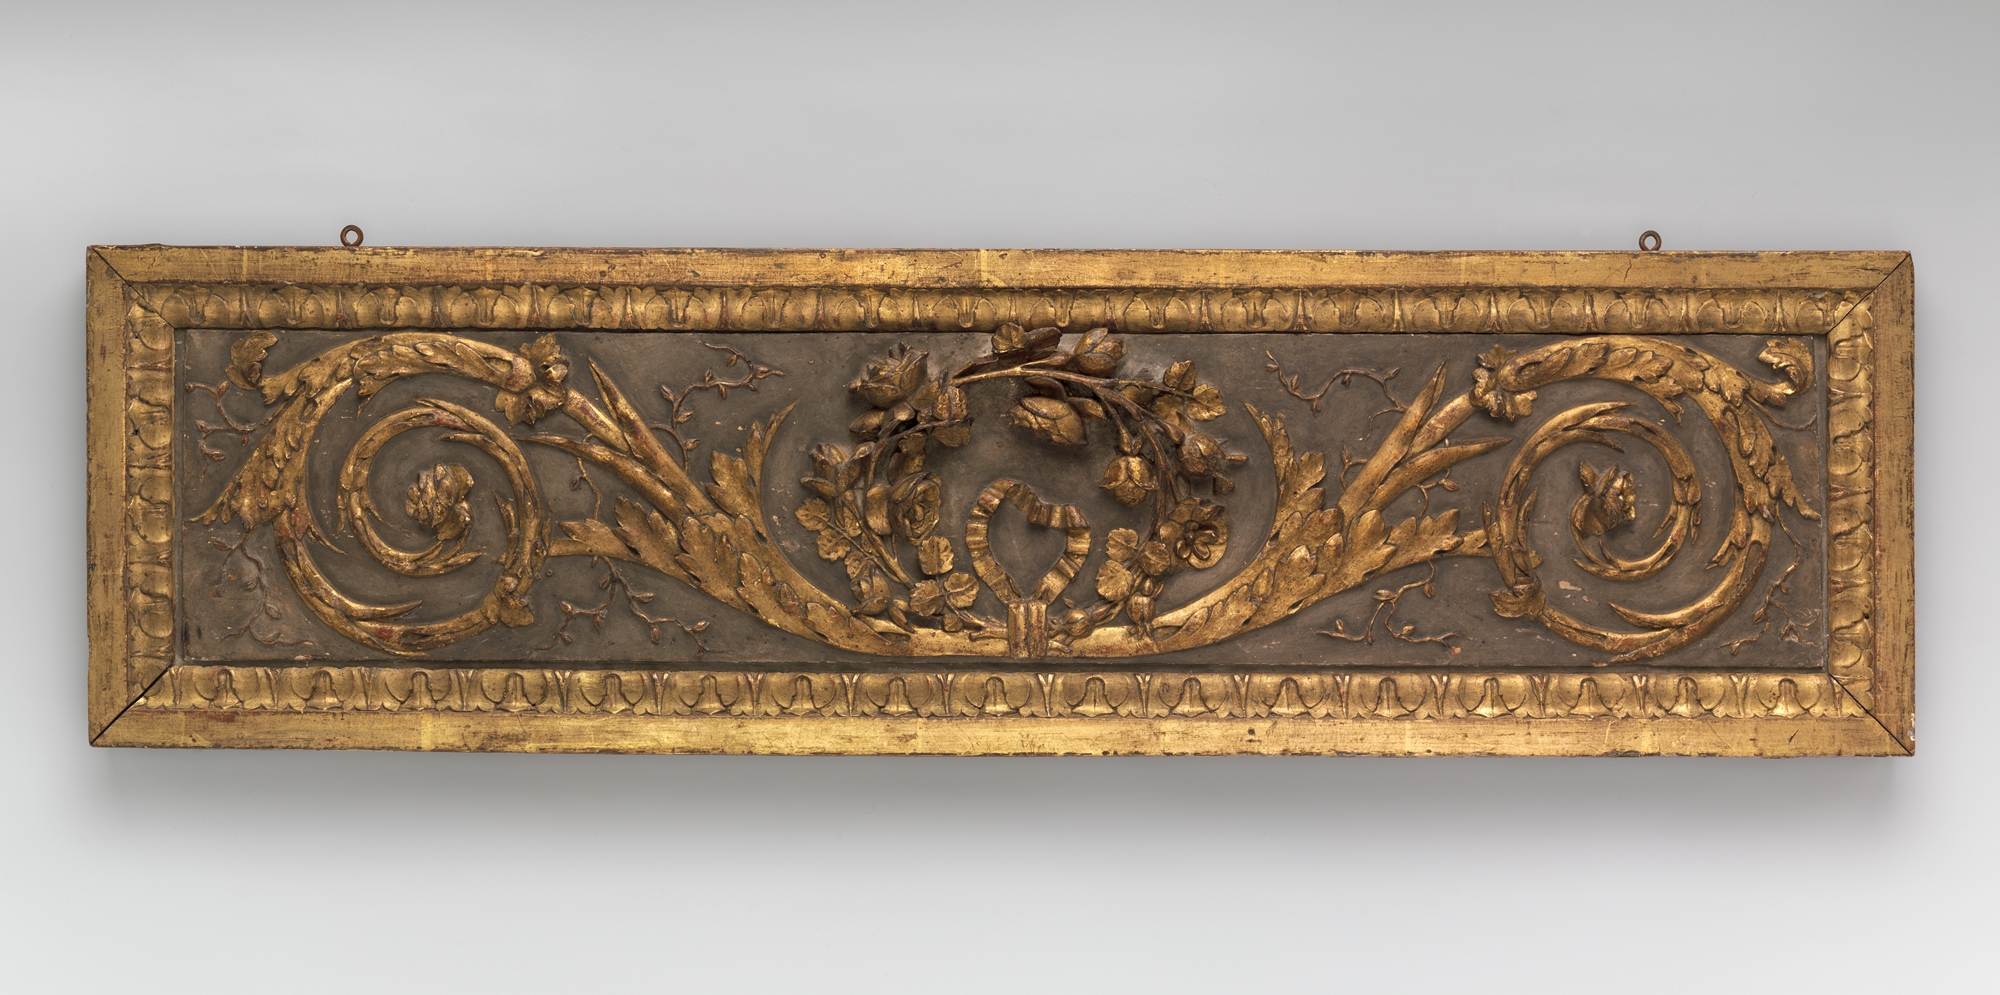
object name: panel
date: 1701-1800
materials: wood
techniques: gilding, painting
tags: roses